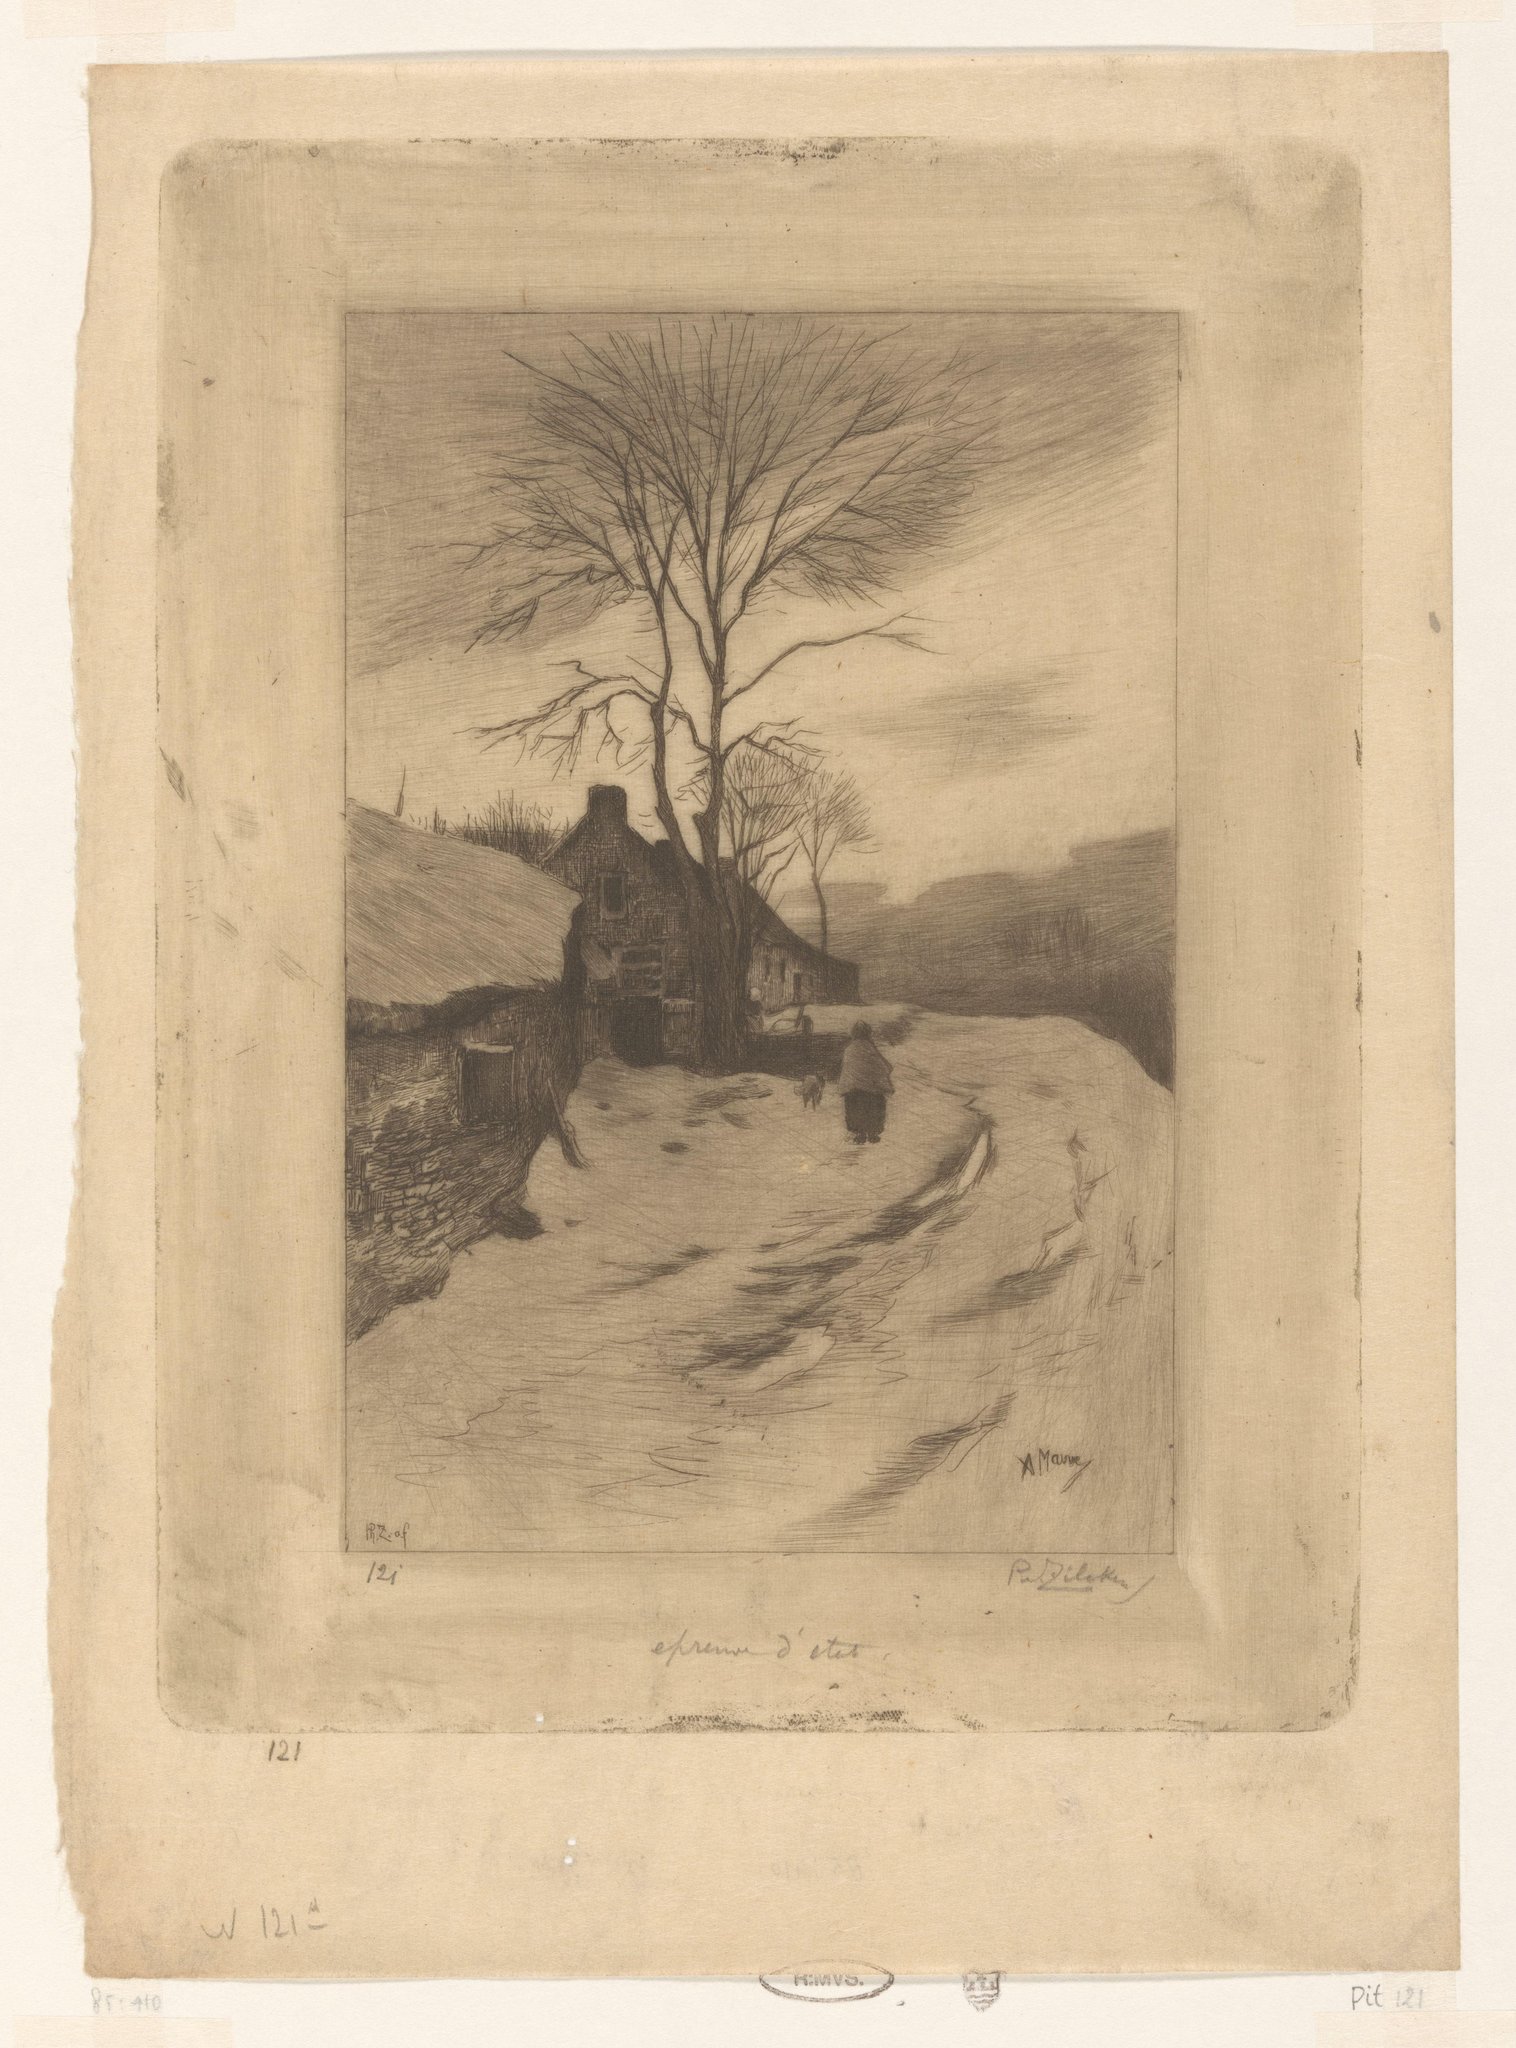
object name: print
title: Hiver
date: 1867-1890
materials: paper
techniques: drypoint, etching, intaglio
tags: road, path, farm (building)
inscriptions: collector's mark: Lugt 2760, collector's mark: Lugt 2228